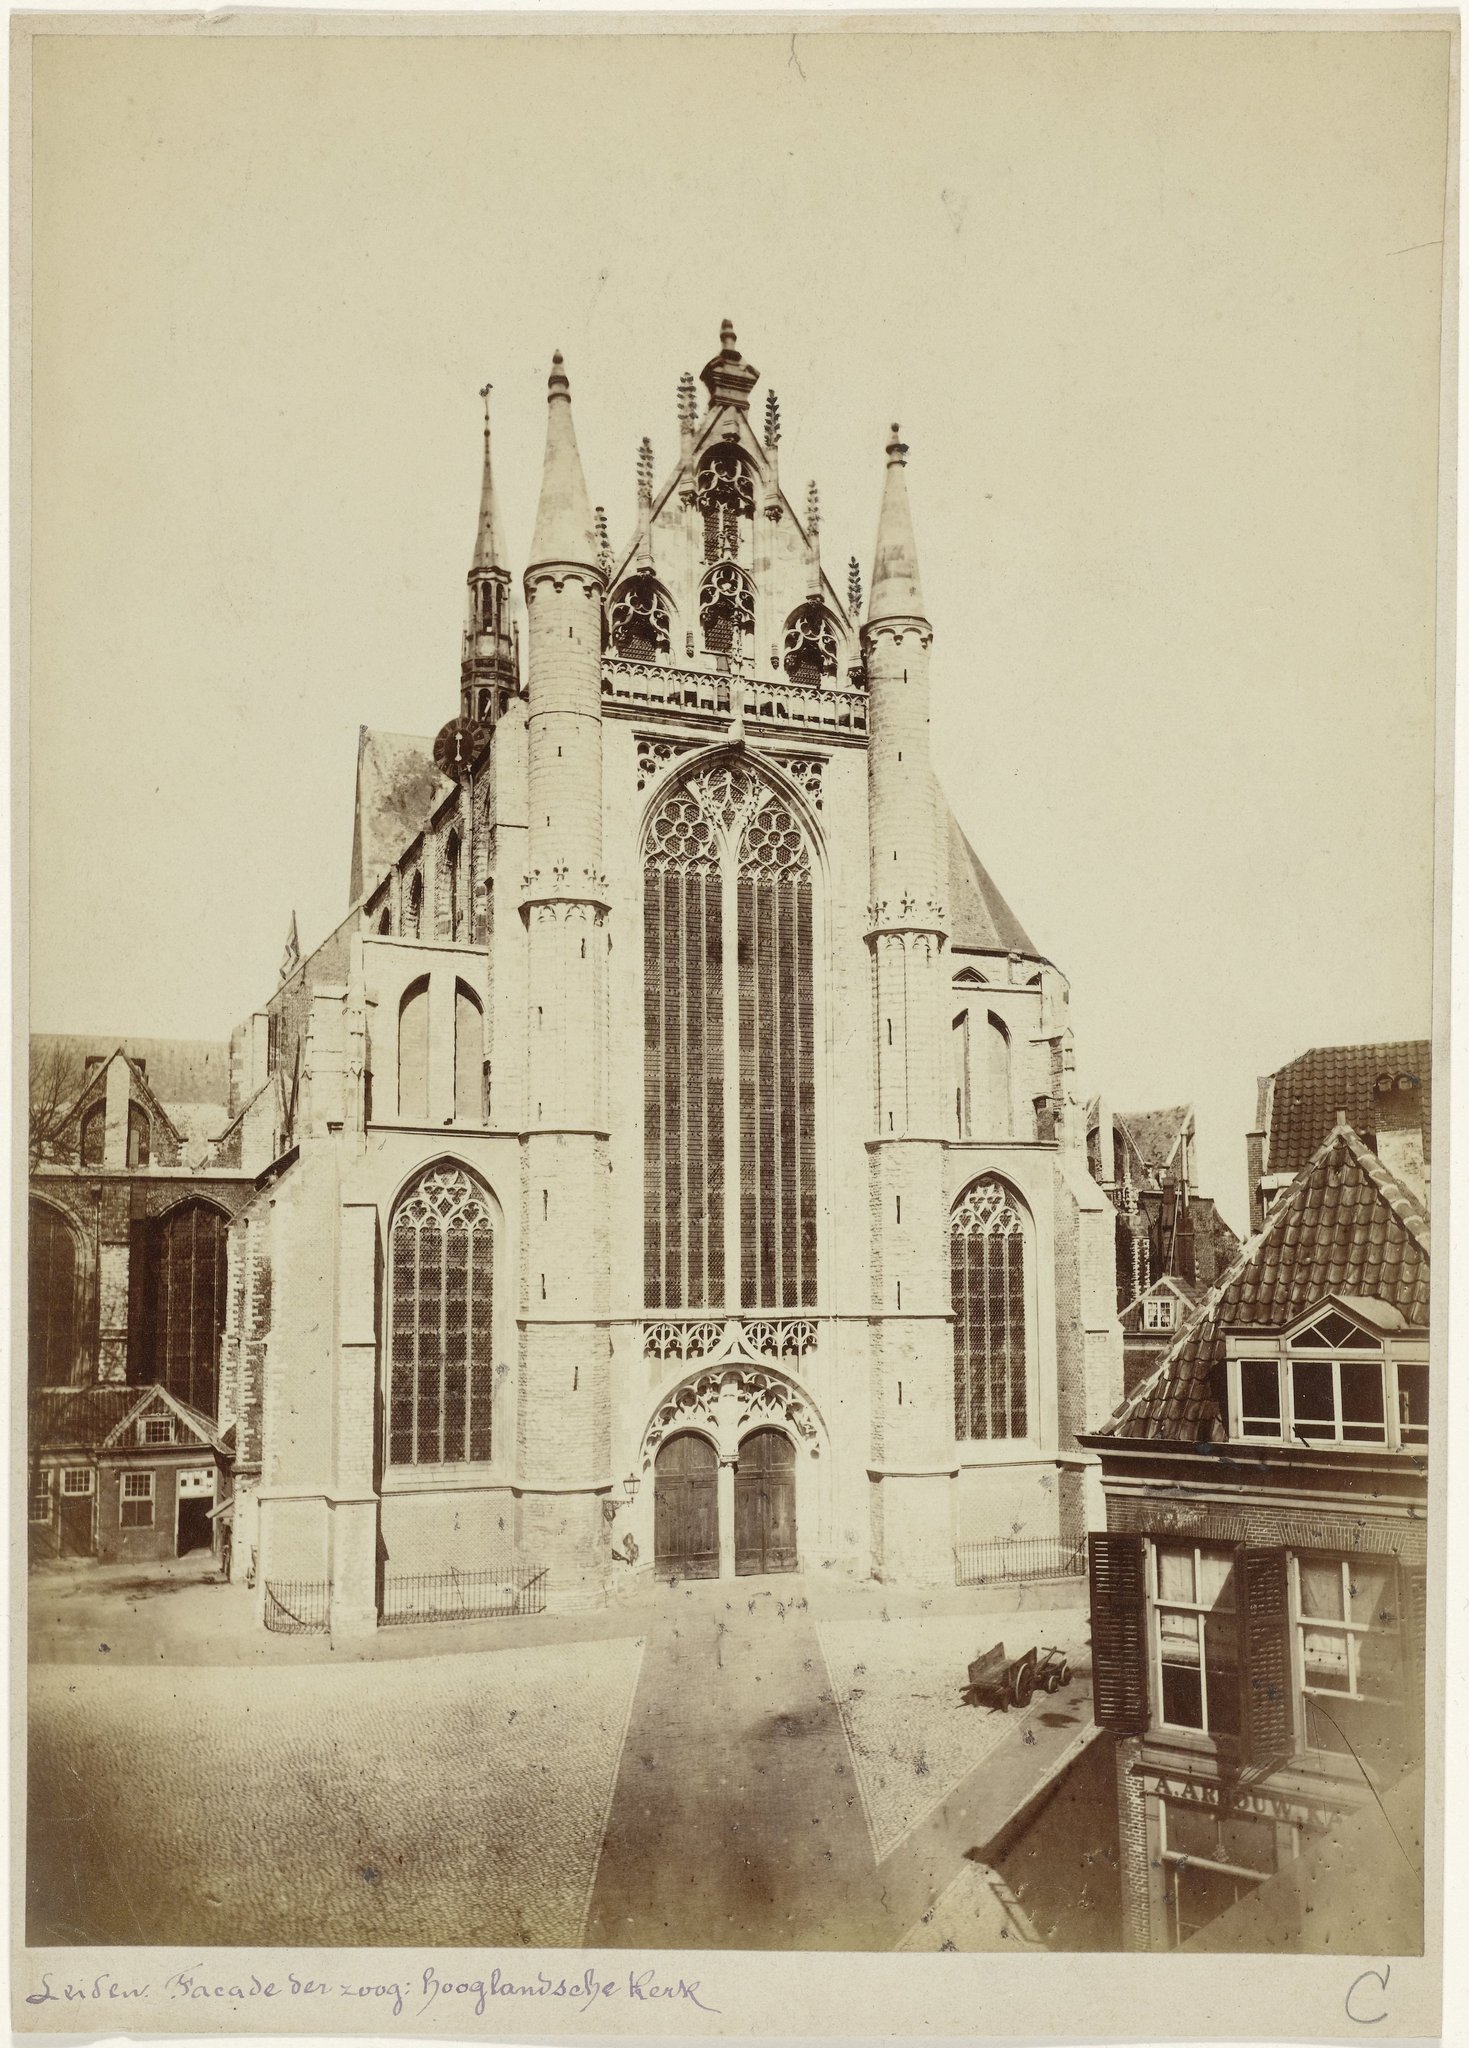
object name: photograph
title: Leiden, Facade der zoog: Hooglandsche Kerk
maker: Anonymous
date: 1860-1900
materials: cardboard, photographic support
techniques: albumen print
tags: hooglandse kerk